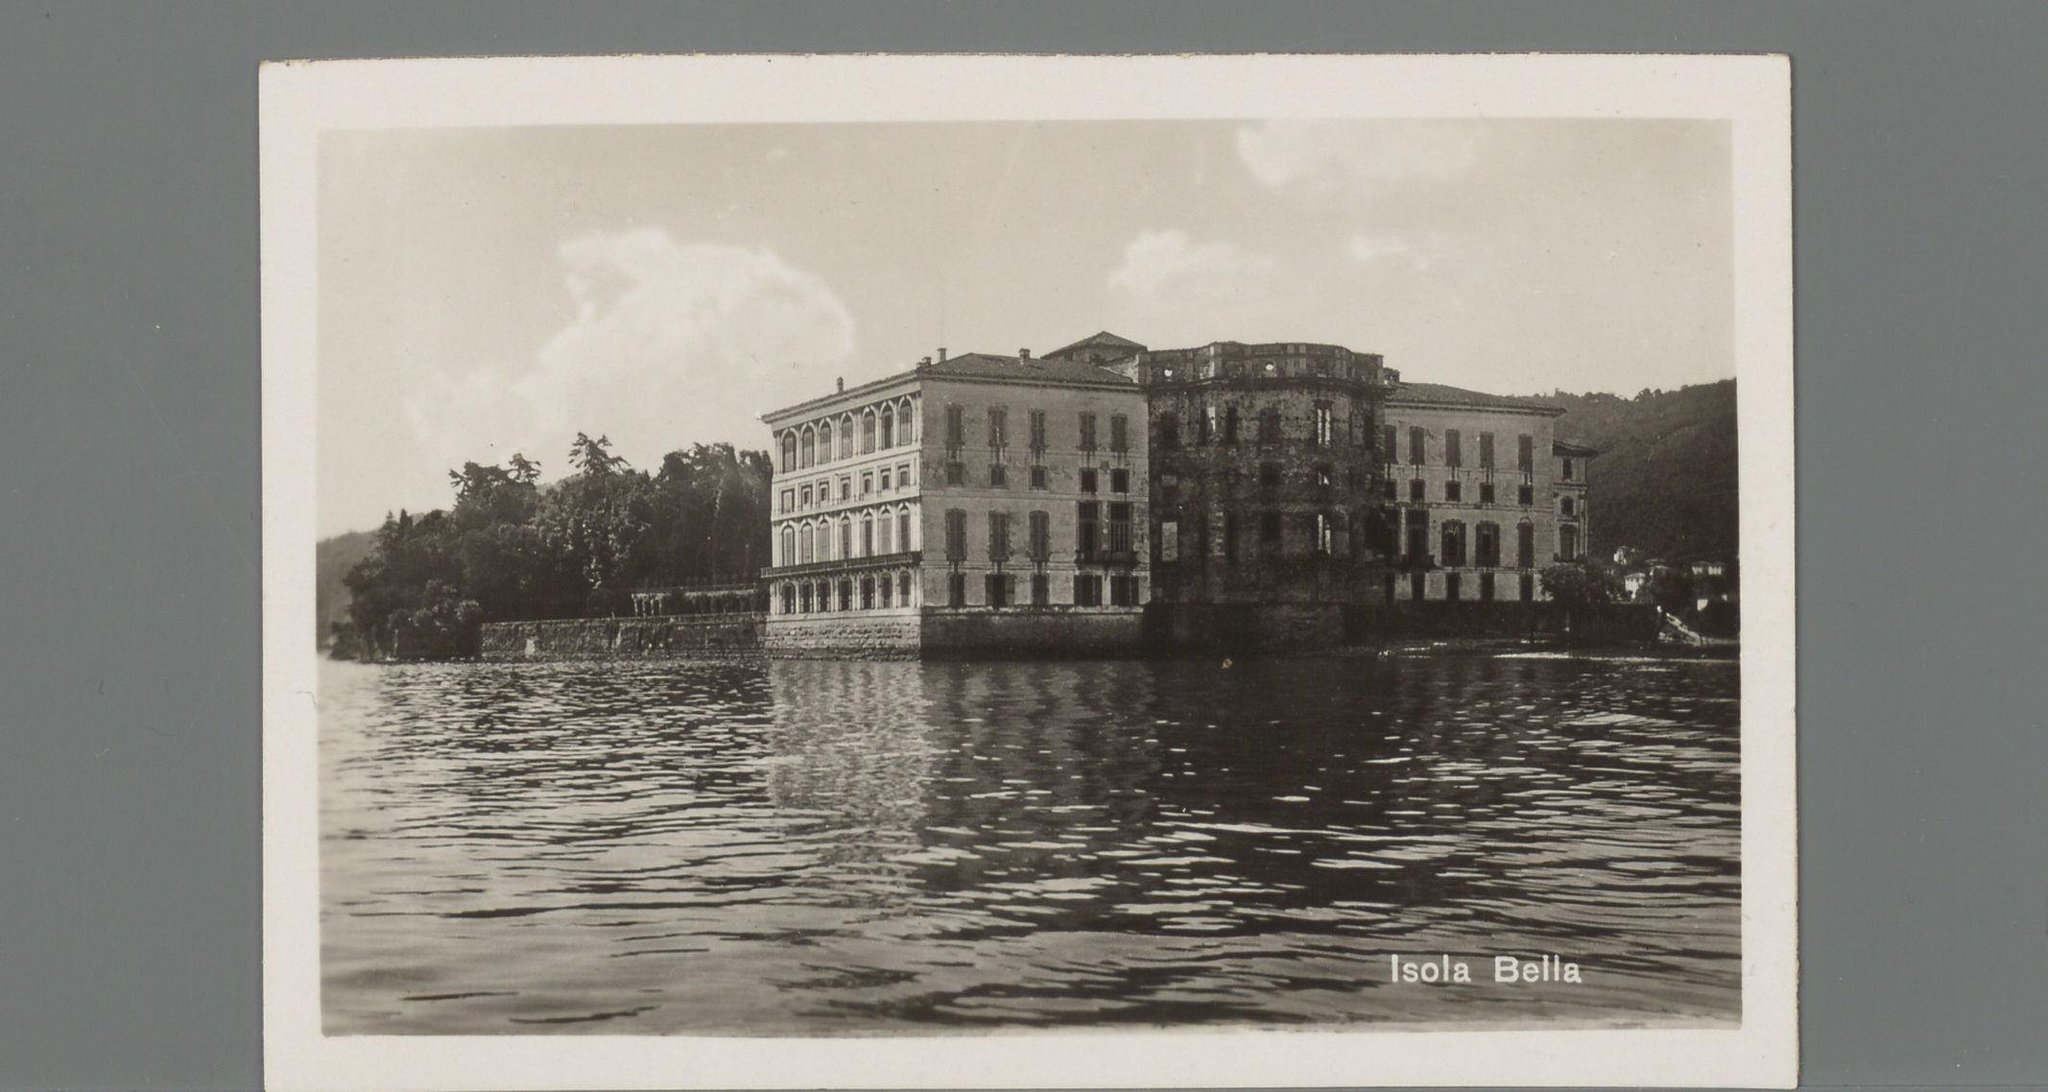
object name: photograph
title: Pallanza ed Isole Borromee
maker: Anonymous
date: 1904-1935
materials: photographic support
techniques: photography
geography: como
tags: lake, edifice, e.g.: public building, department store